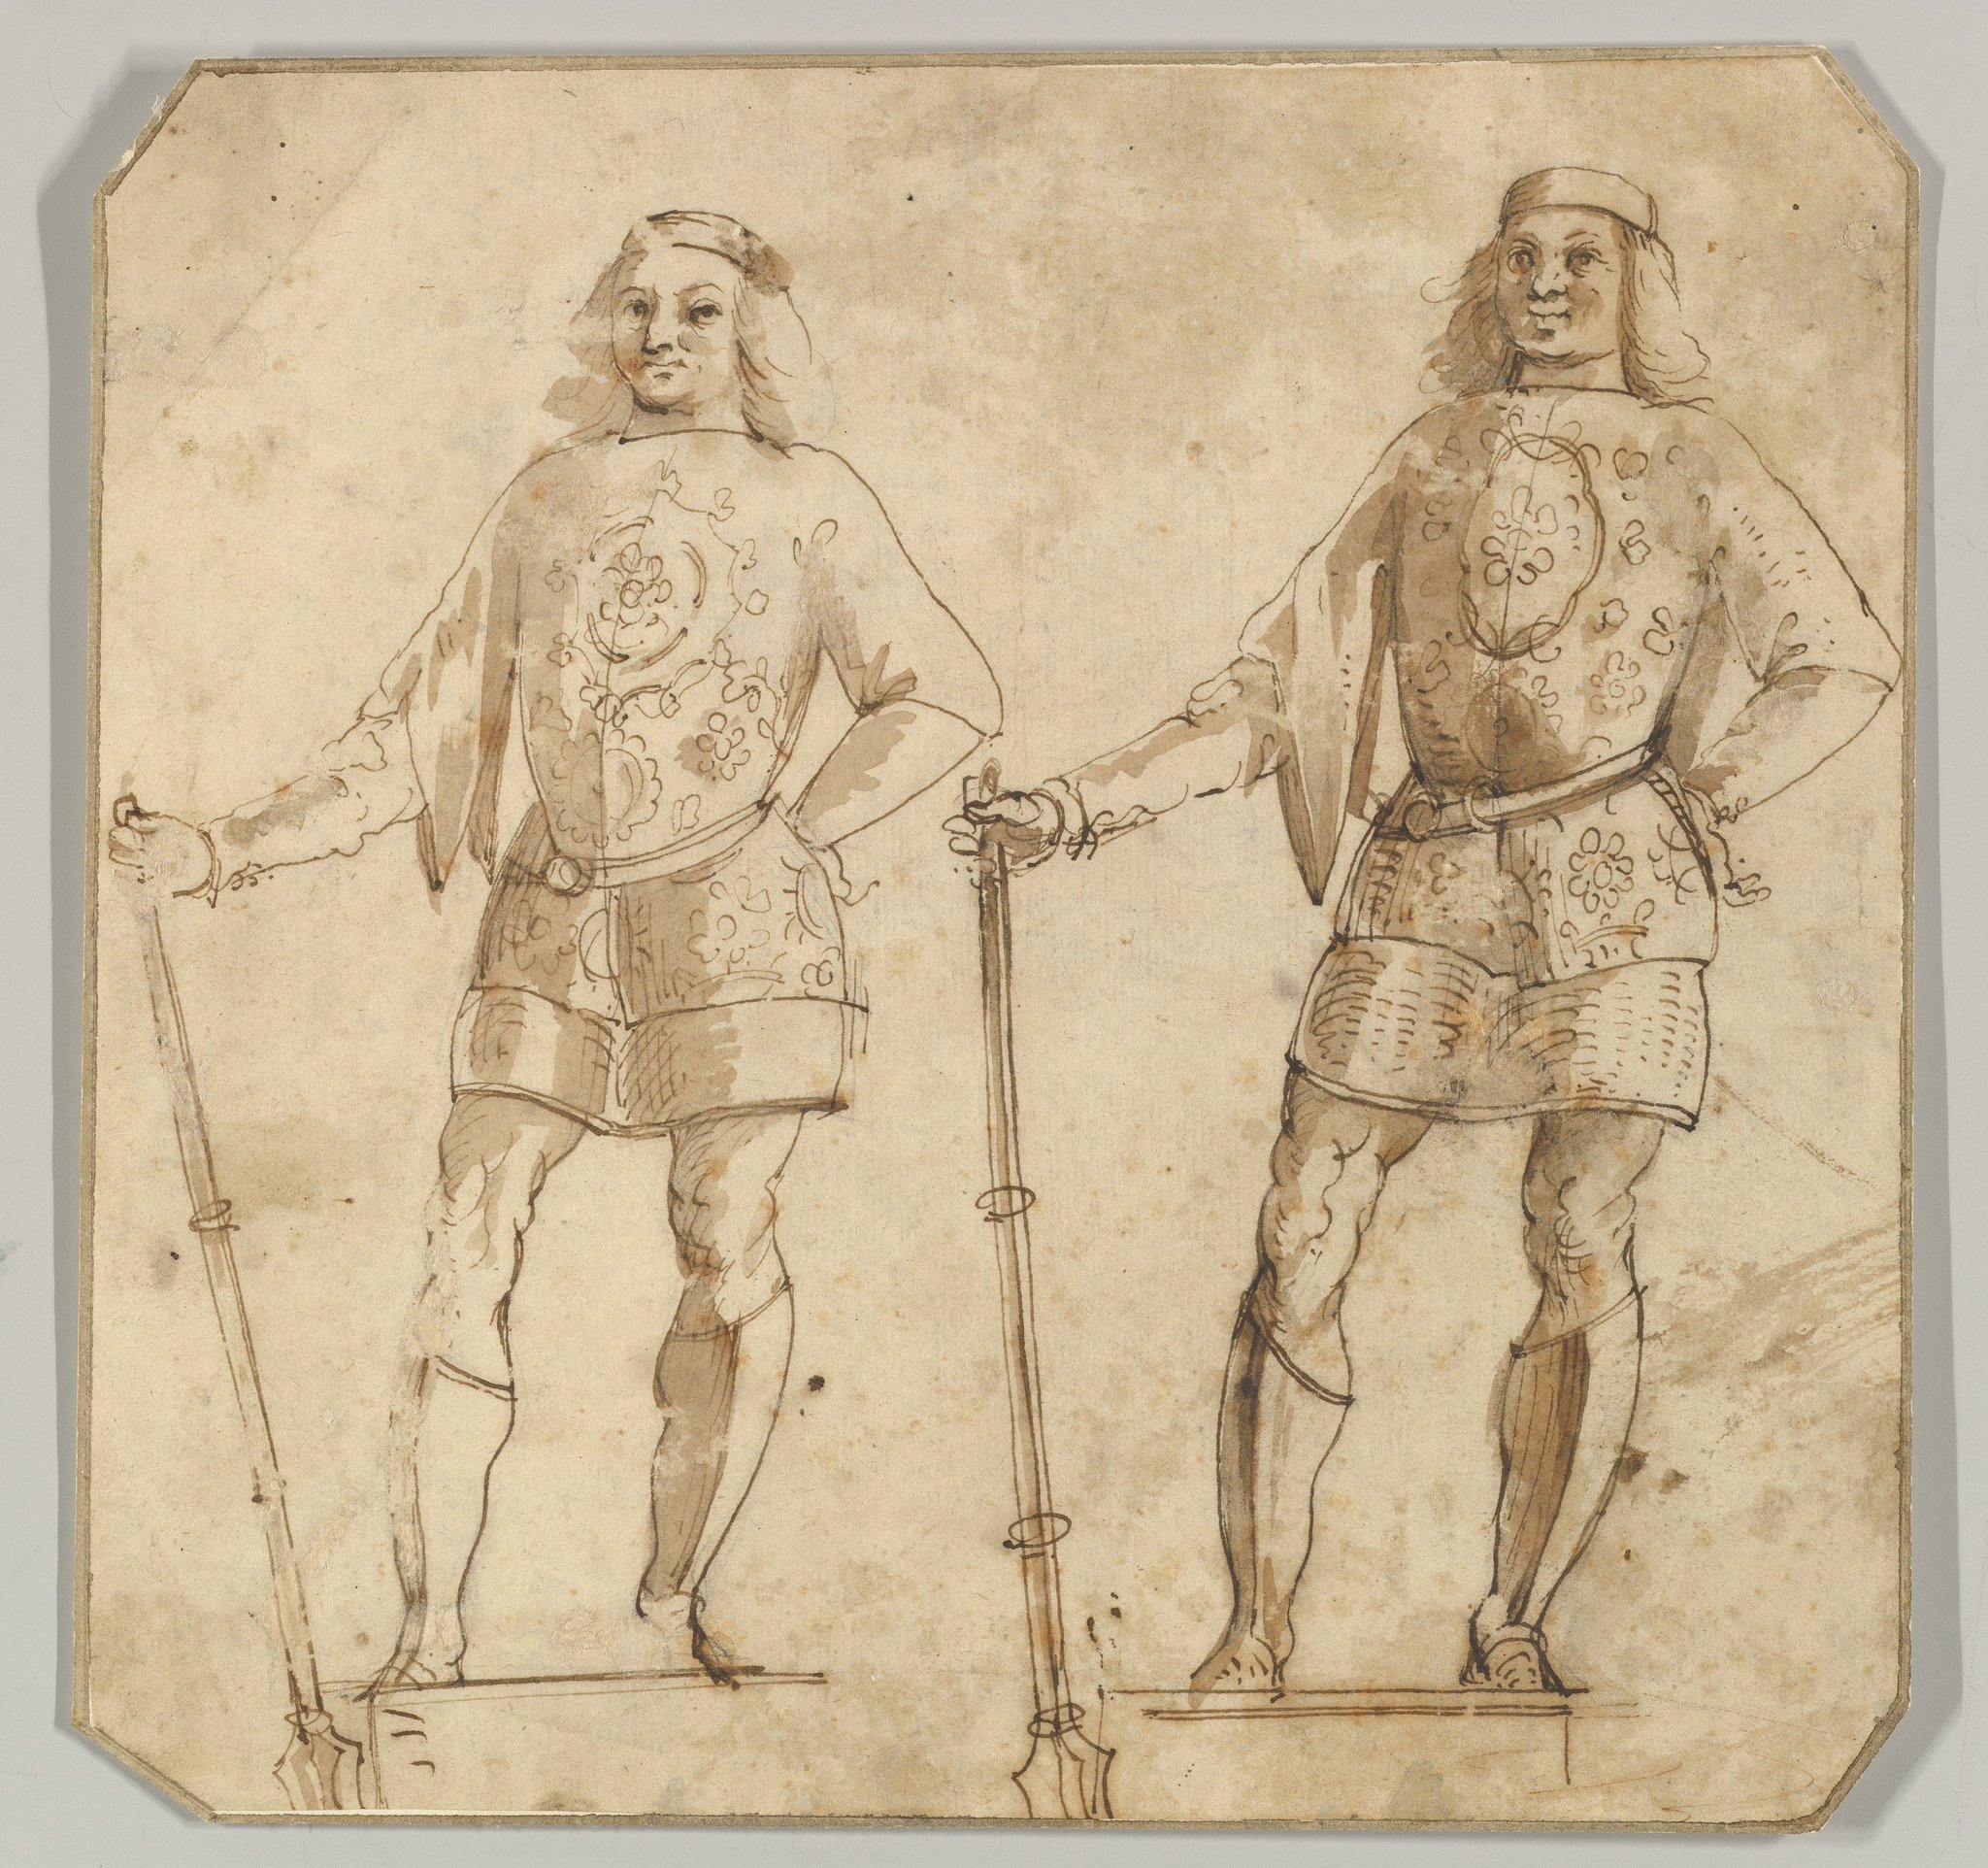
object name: drawing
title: Studies of a Soldier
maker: giovanni buonconsiglio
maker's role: artist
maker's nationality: italian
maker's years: 1470-1538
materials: chalk, ink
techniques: pen, wash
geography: italy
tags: soldiers,spears,men